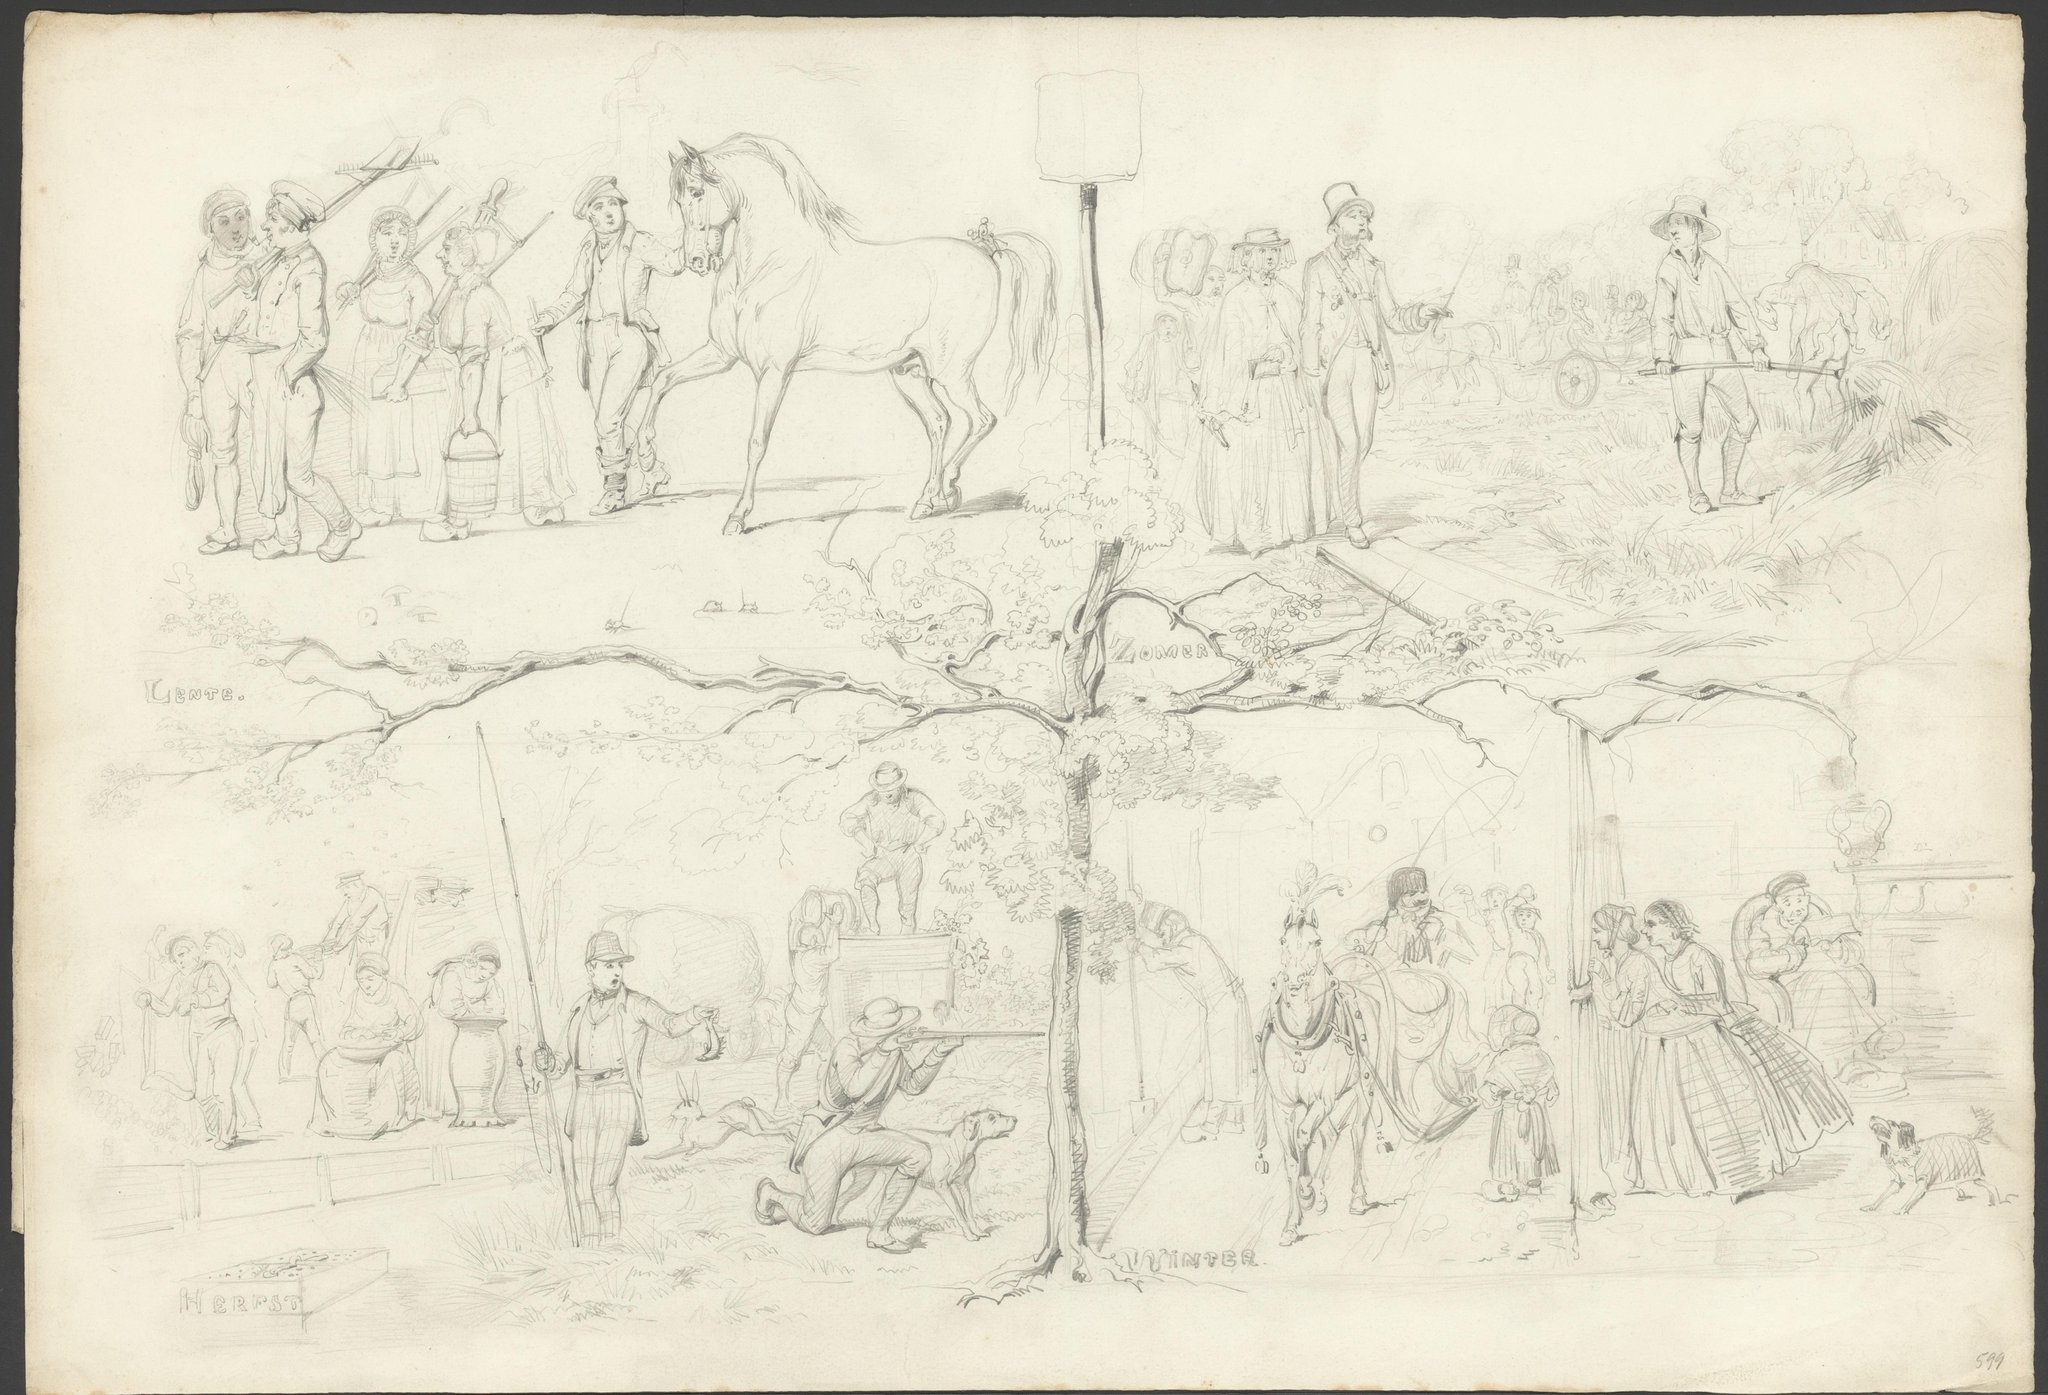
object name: drawing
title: Vier seizoenen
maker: karel frederik bombled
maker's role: draughtsman, print maker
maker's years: 1822-1902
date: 1864-1902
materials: paper, pencil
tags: harvest, hunting, chase, throwing snowballs, agriculture, the four seasons of the year ~ human activities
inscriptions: stamp, collector's mark: Lugt 1641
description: Ontwerp voor het AB boek van Karel Frederik Bombled. Een boom verdeelt het blad in vier vakken. In iedere tak linksonder de naam van een jaargetij. Linksboven lente met mannen en vrouwen met landbouwwerktuigen en een paard. Rechtsboven zomer met gegoed stel kijken naar boeren die aan het hooien zijn. Linksonder herfst met het verwerken van de oogst, een visser en een jager. Rechtsonder winter met twee meisjes die door het raam naar buiten kijken waar er met sneeuwballen wordt gegooid. Onderwerpsrubrieken binnen de Atlas Zeden en Gewoonten: Schoone kunsten, Schilderkunst, Tekeningen.